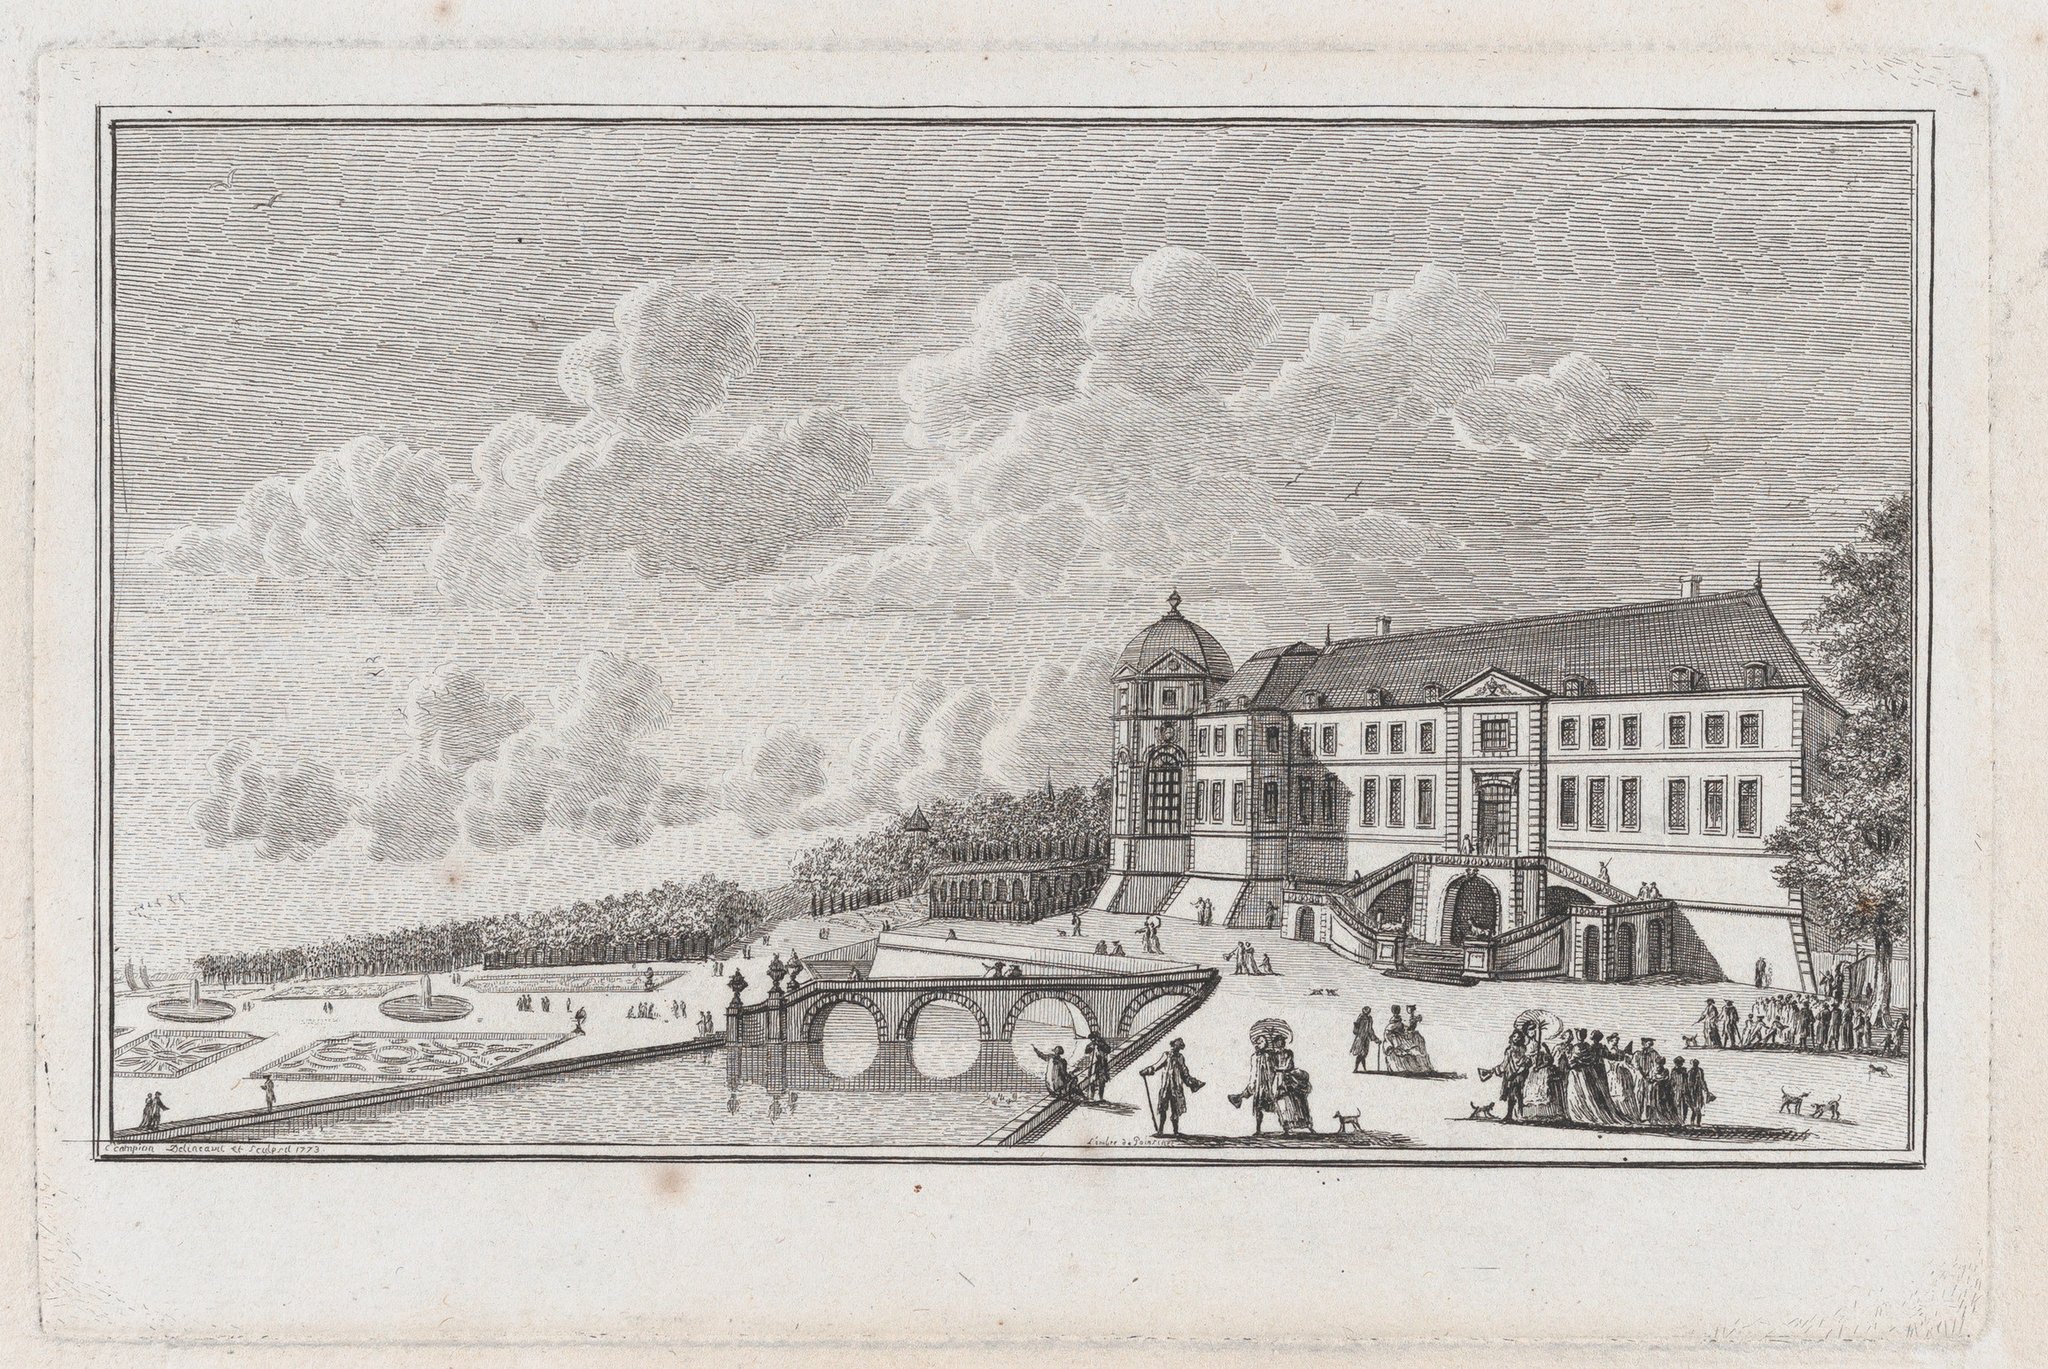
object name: print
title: The Shadow of Poinsinet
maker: charles michel campion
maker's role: artist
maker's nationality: french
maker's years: 1734-1784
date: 1773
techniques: etching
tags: buildings,gardens